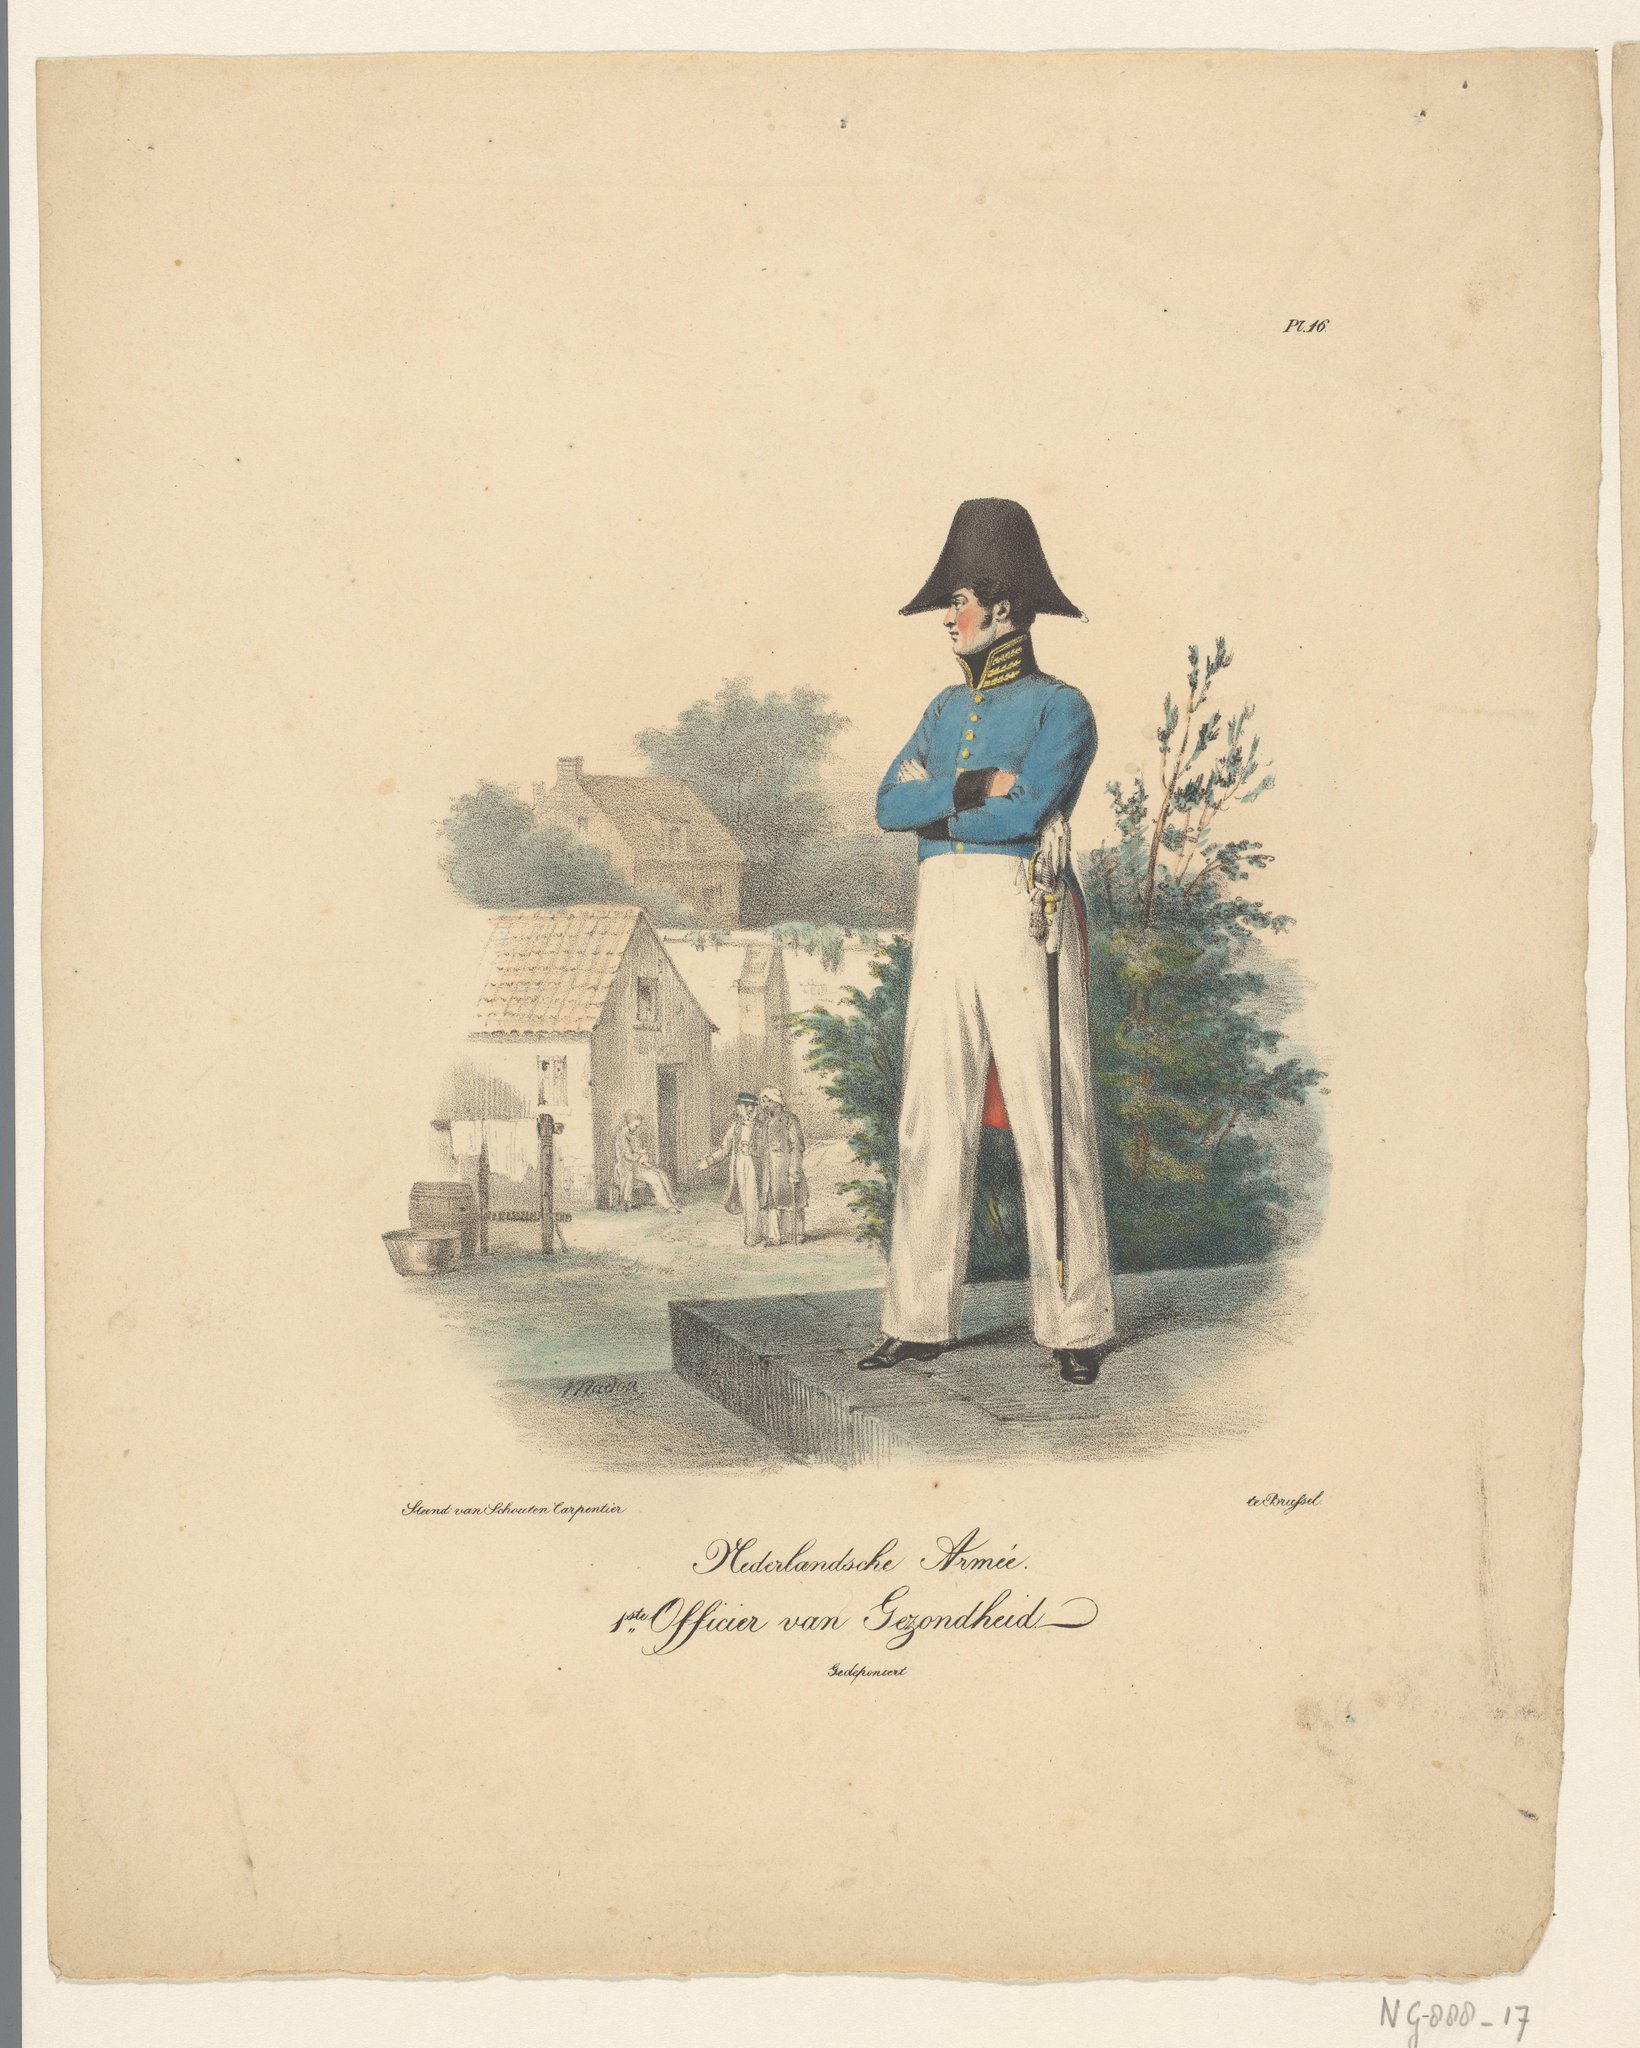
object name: costume print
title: Nederlandsche Armée / 1ste Officier van Gezondheid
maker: jean baptiste madou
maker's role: draughtsman, painter, print maker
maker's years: 1796-1877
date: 1823-1827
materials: paper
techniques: hand coloring, lithograph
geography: brussels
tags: (military) uniforms (+ auxiliary corps)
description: Een officier van gezondheid 1e klasse, staande met de armen over elkaar. Genummerd rechtsboven: 16. Afkomstig uit een plaatwerk van uniformen van het Nederlandse leger, ca. 1825.